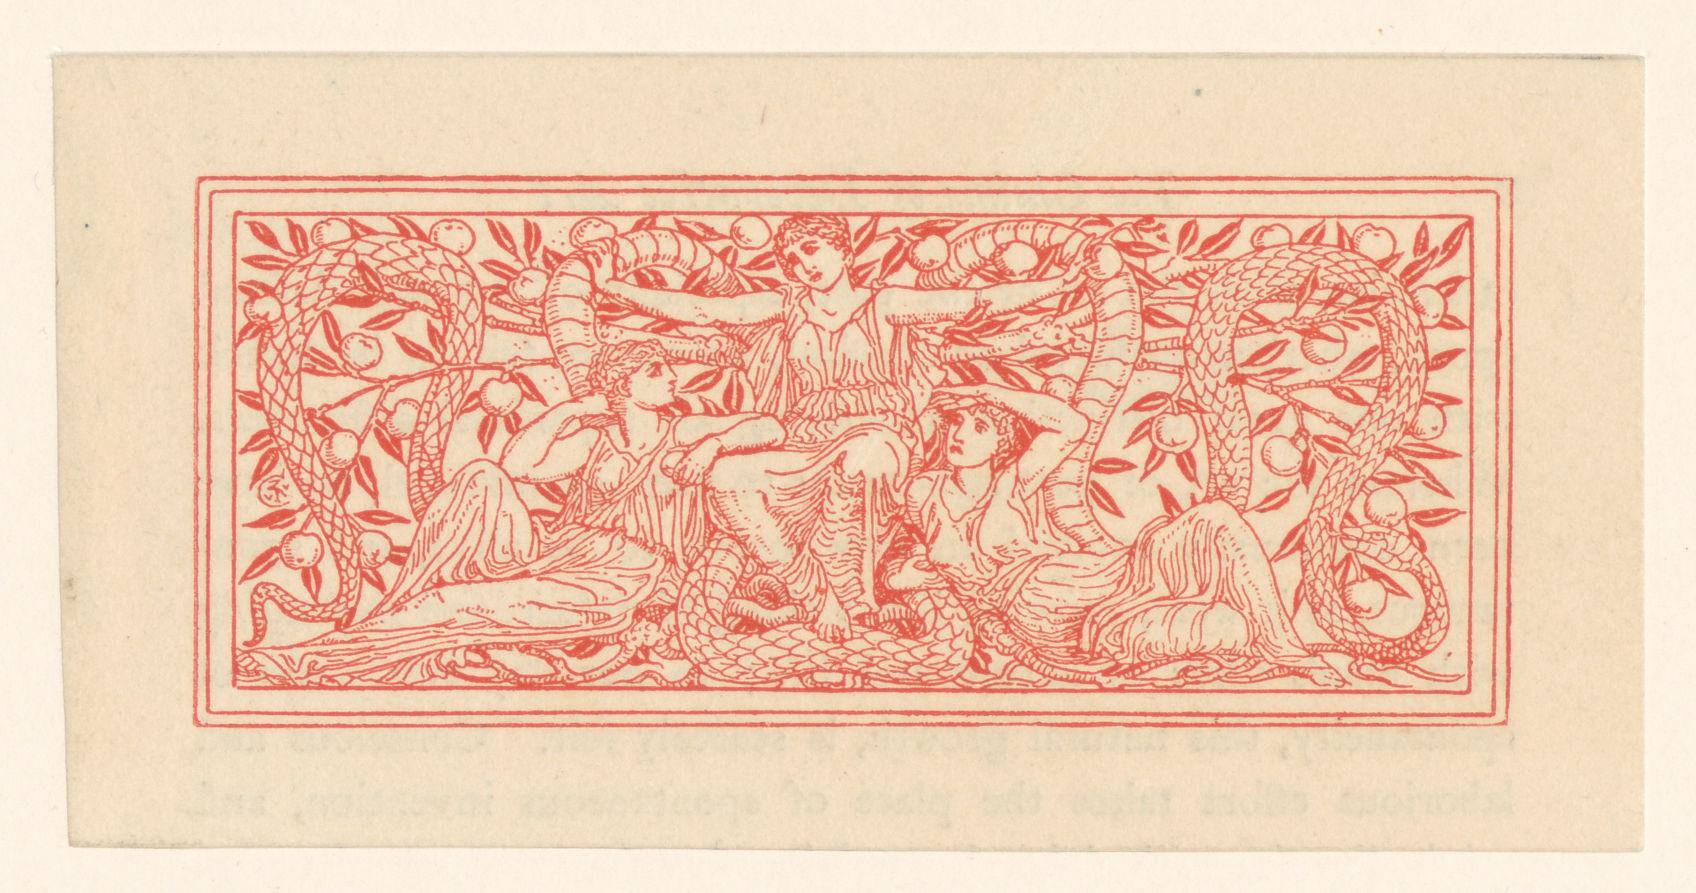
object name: book illustration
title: Drie vrouwen omringd door takken van een citroenboom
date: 1892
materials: paper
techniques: letterpress printing, engraving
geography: london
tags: fruit, adult woman (+ three persons), foliage, tendrils, branches ~ ornament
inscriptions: collector's mark: Lugt 2228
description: Prent uit: Crane, Walter. The claims of decorative art. Londen: Lawrence & Bullen, 1892, p. 7-8.